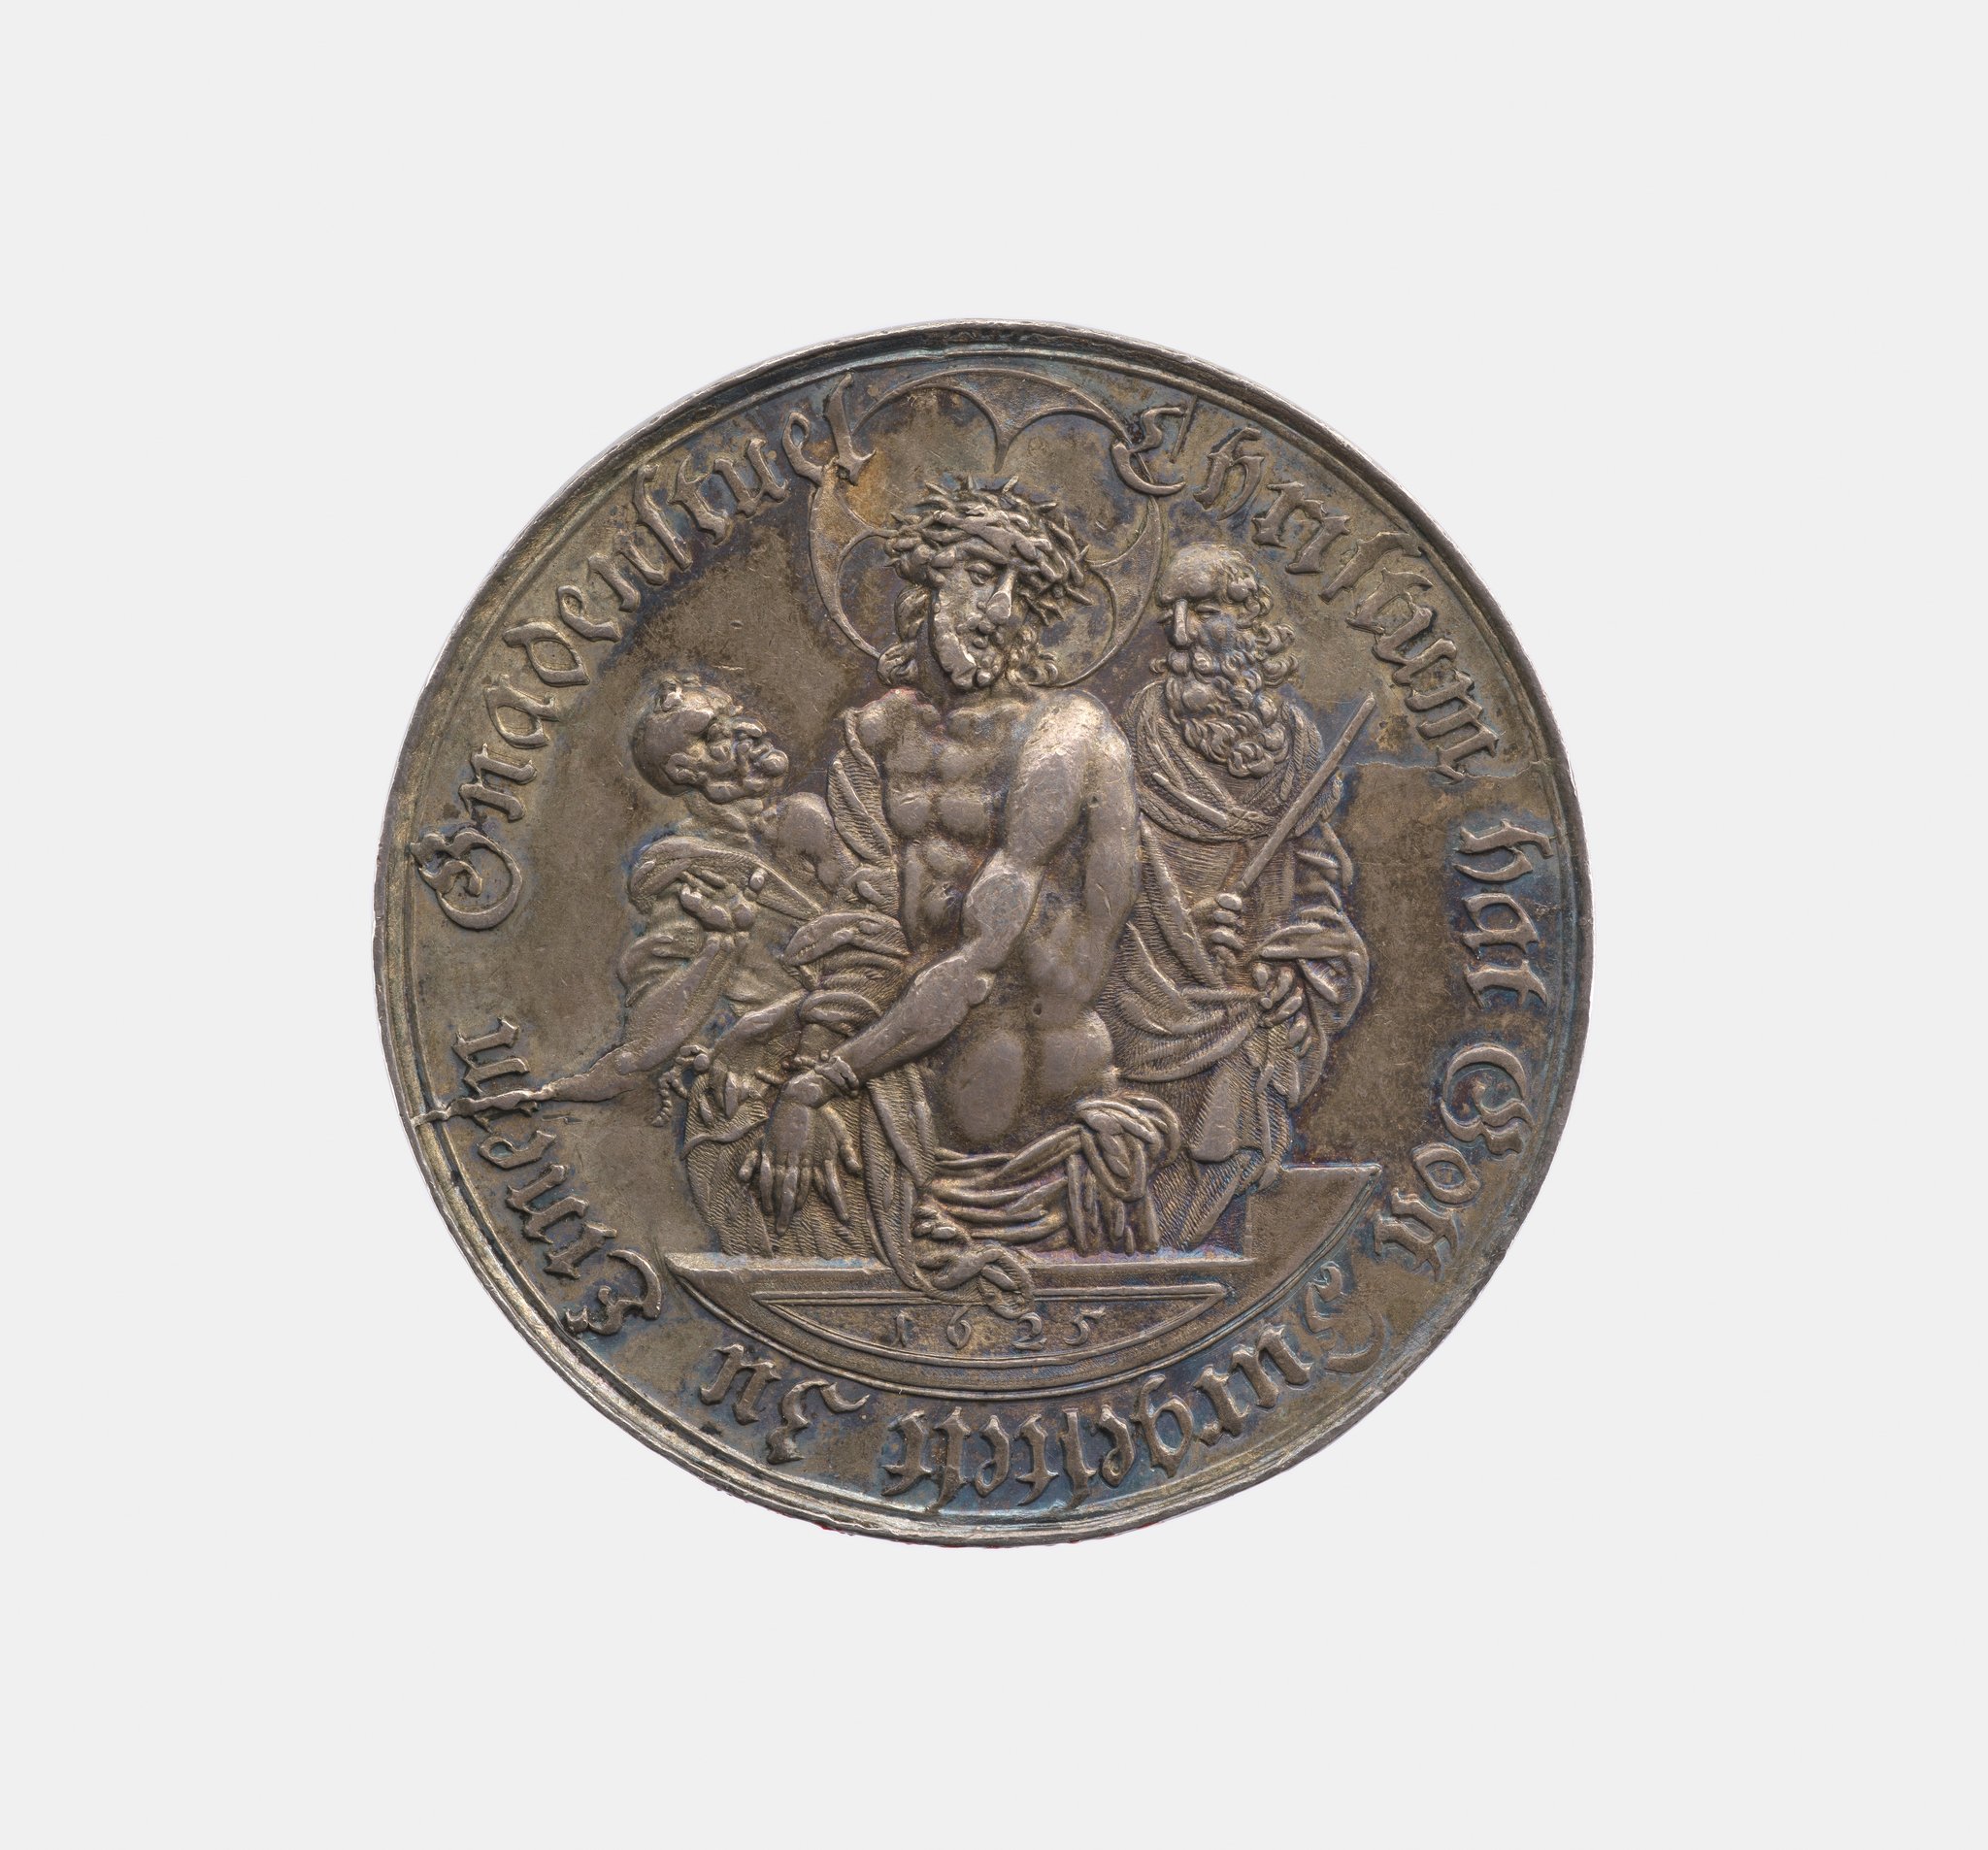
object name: medal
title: Christ and St. Paul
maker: sebastian dadler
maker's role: artist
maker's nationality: german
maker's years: 1586-1657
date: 1625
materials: silver